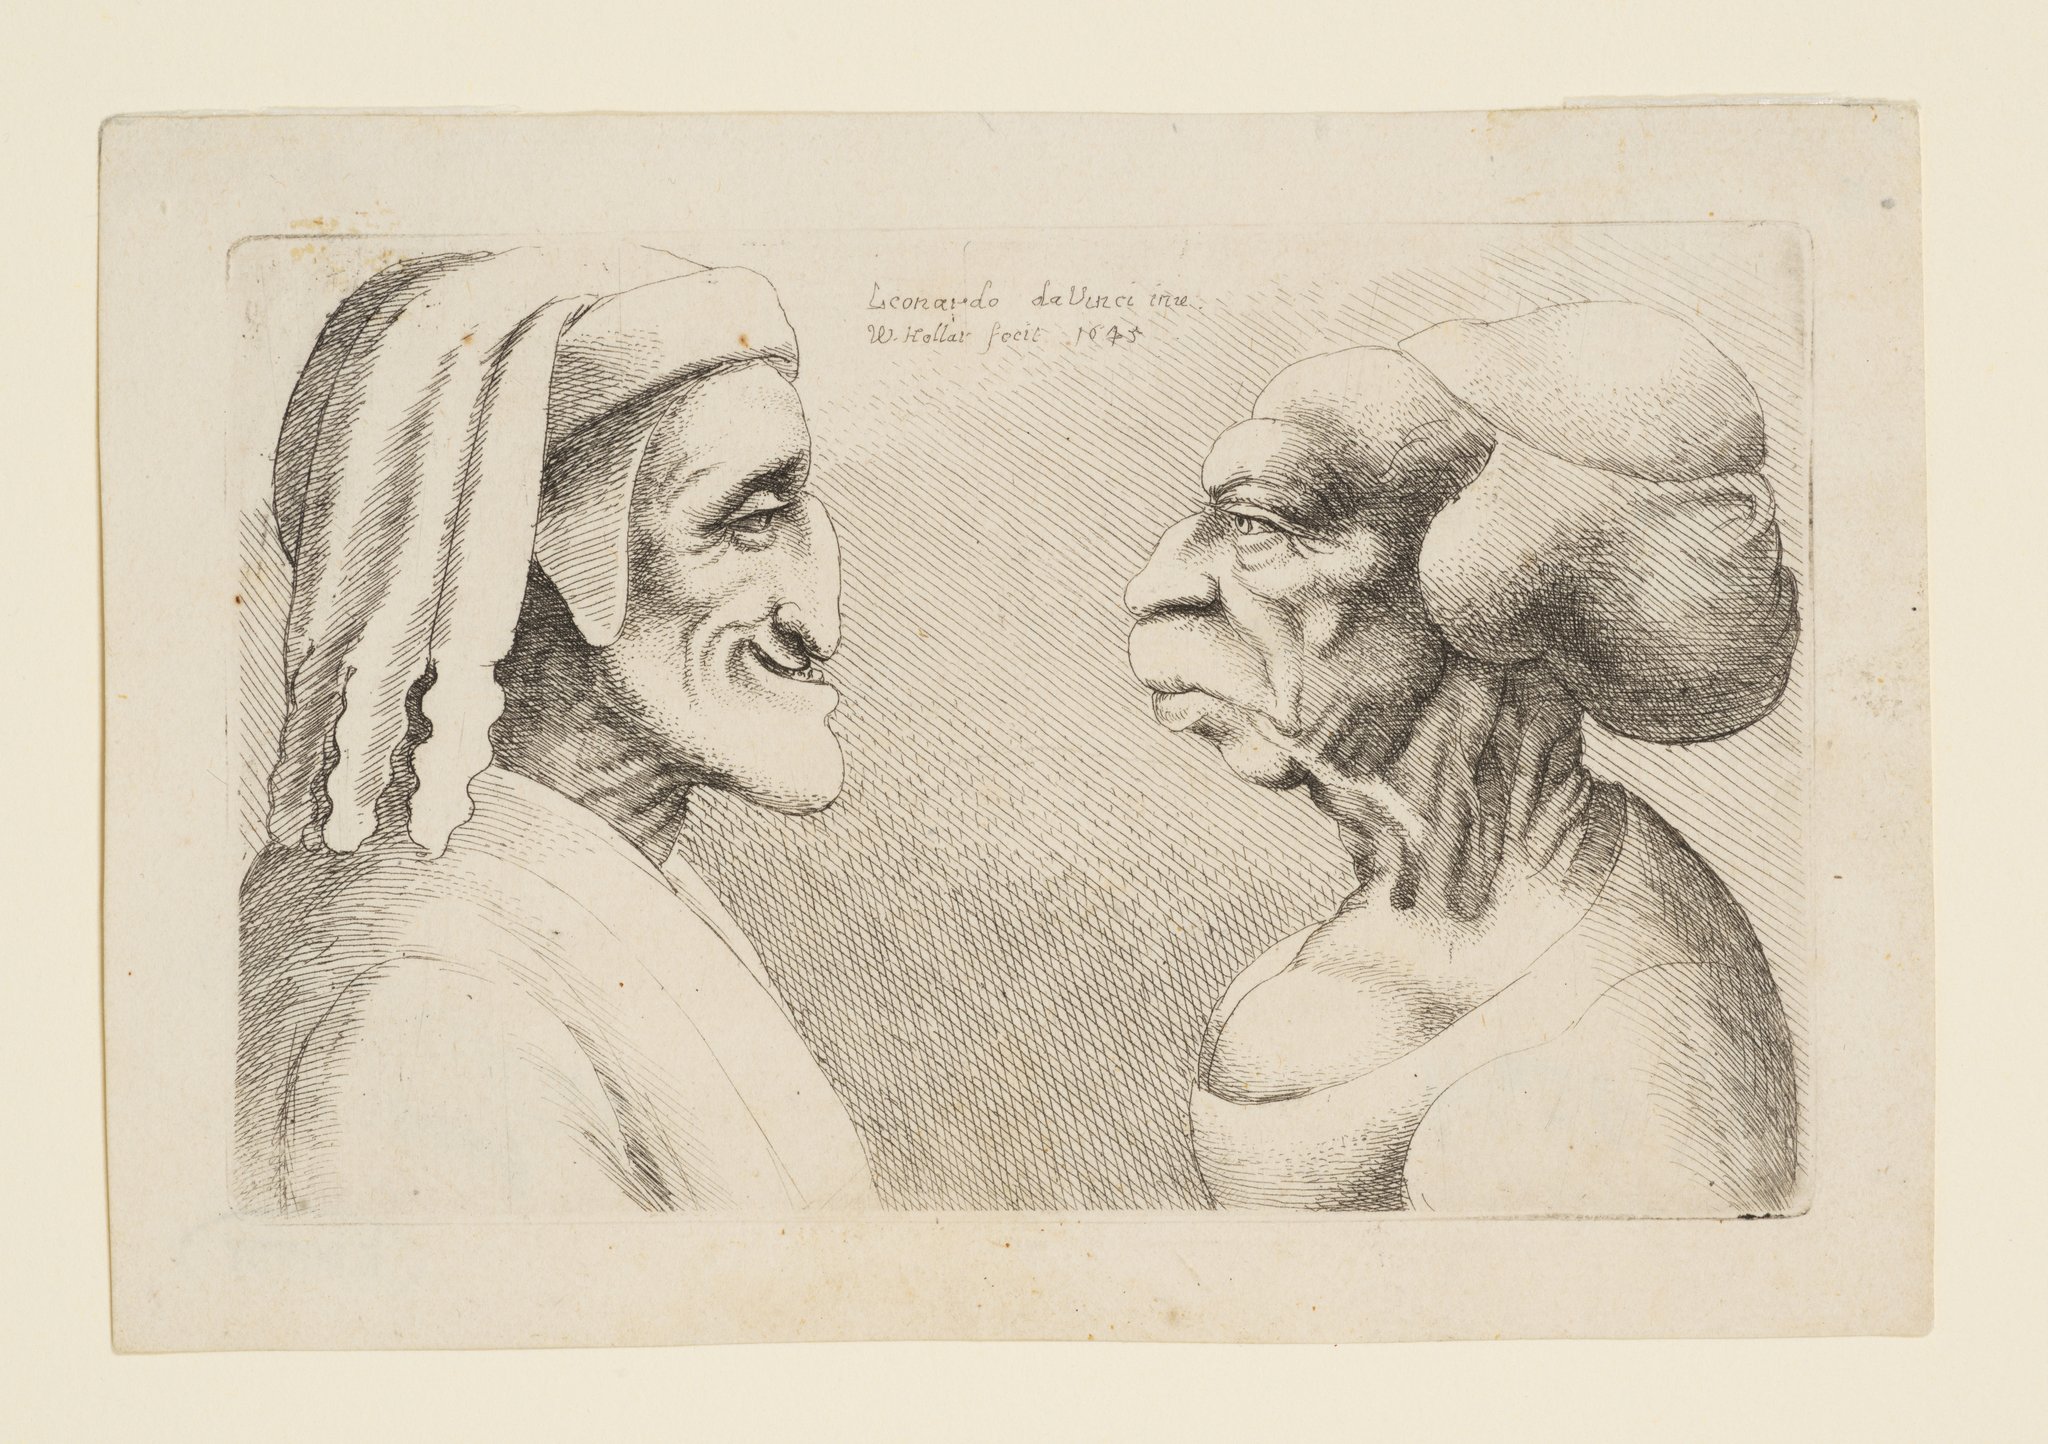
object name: print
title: Two Deformed Heads Facing Inwards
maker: wenceslaus hollar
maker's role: artist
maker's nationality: bohemian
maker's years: 1607-1677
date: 1645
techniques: etching